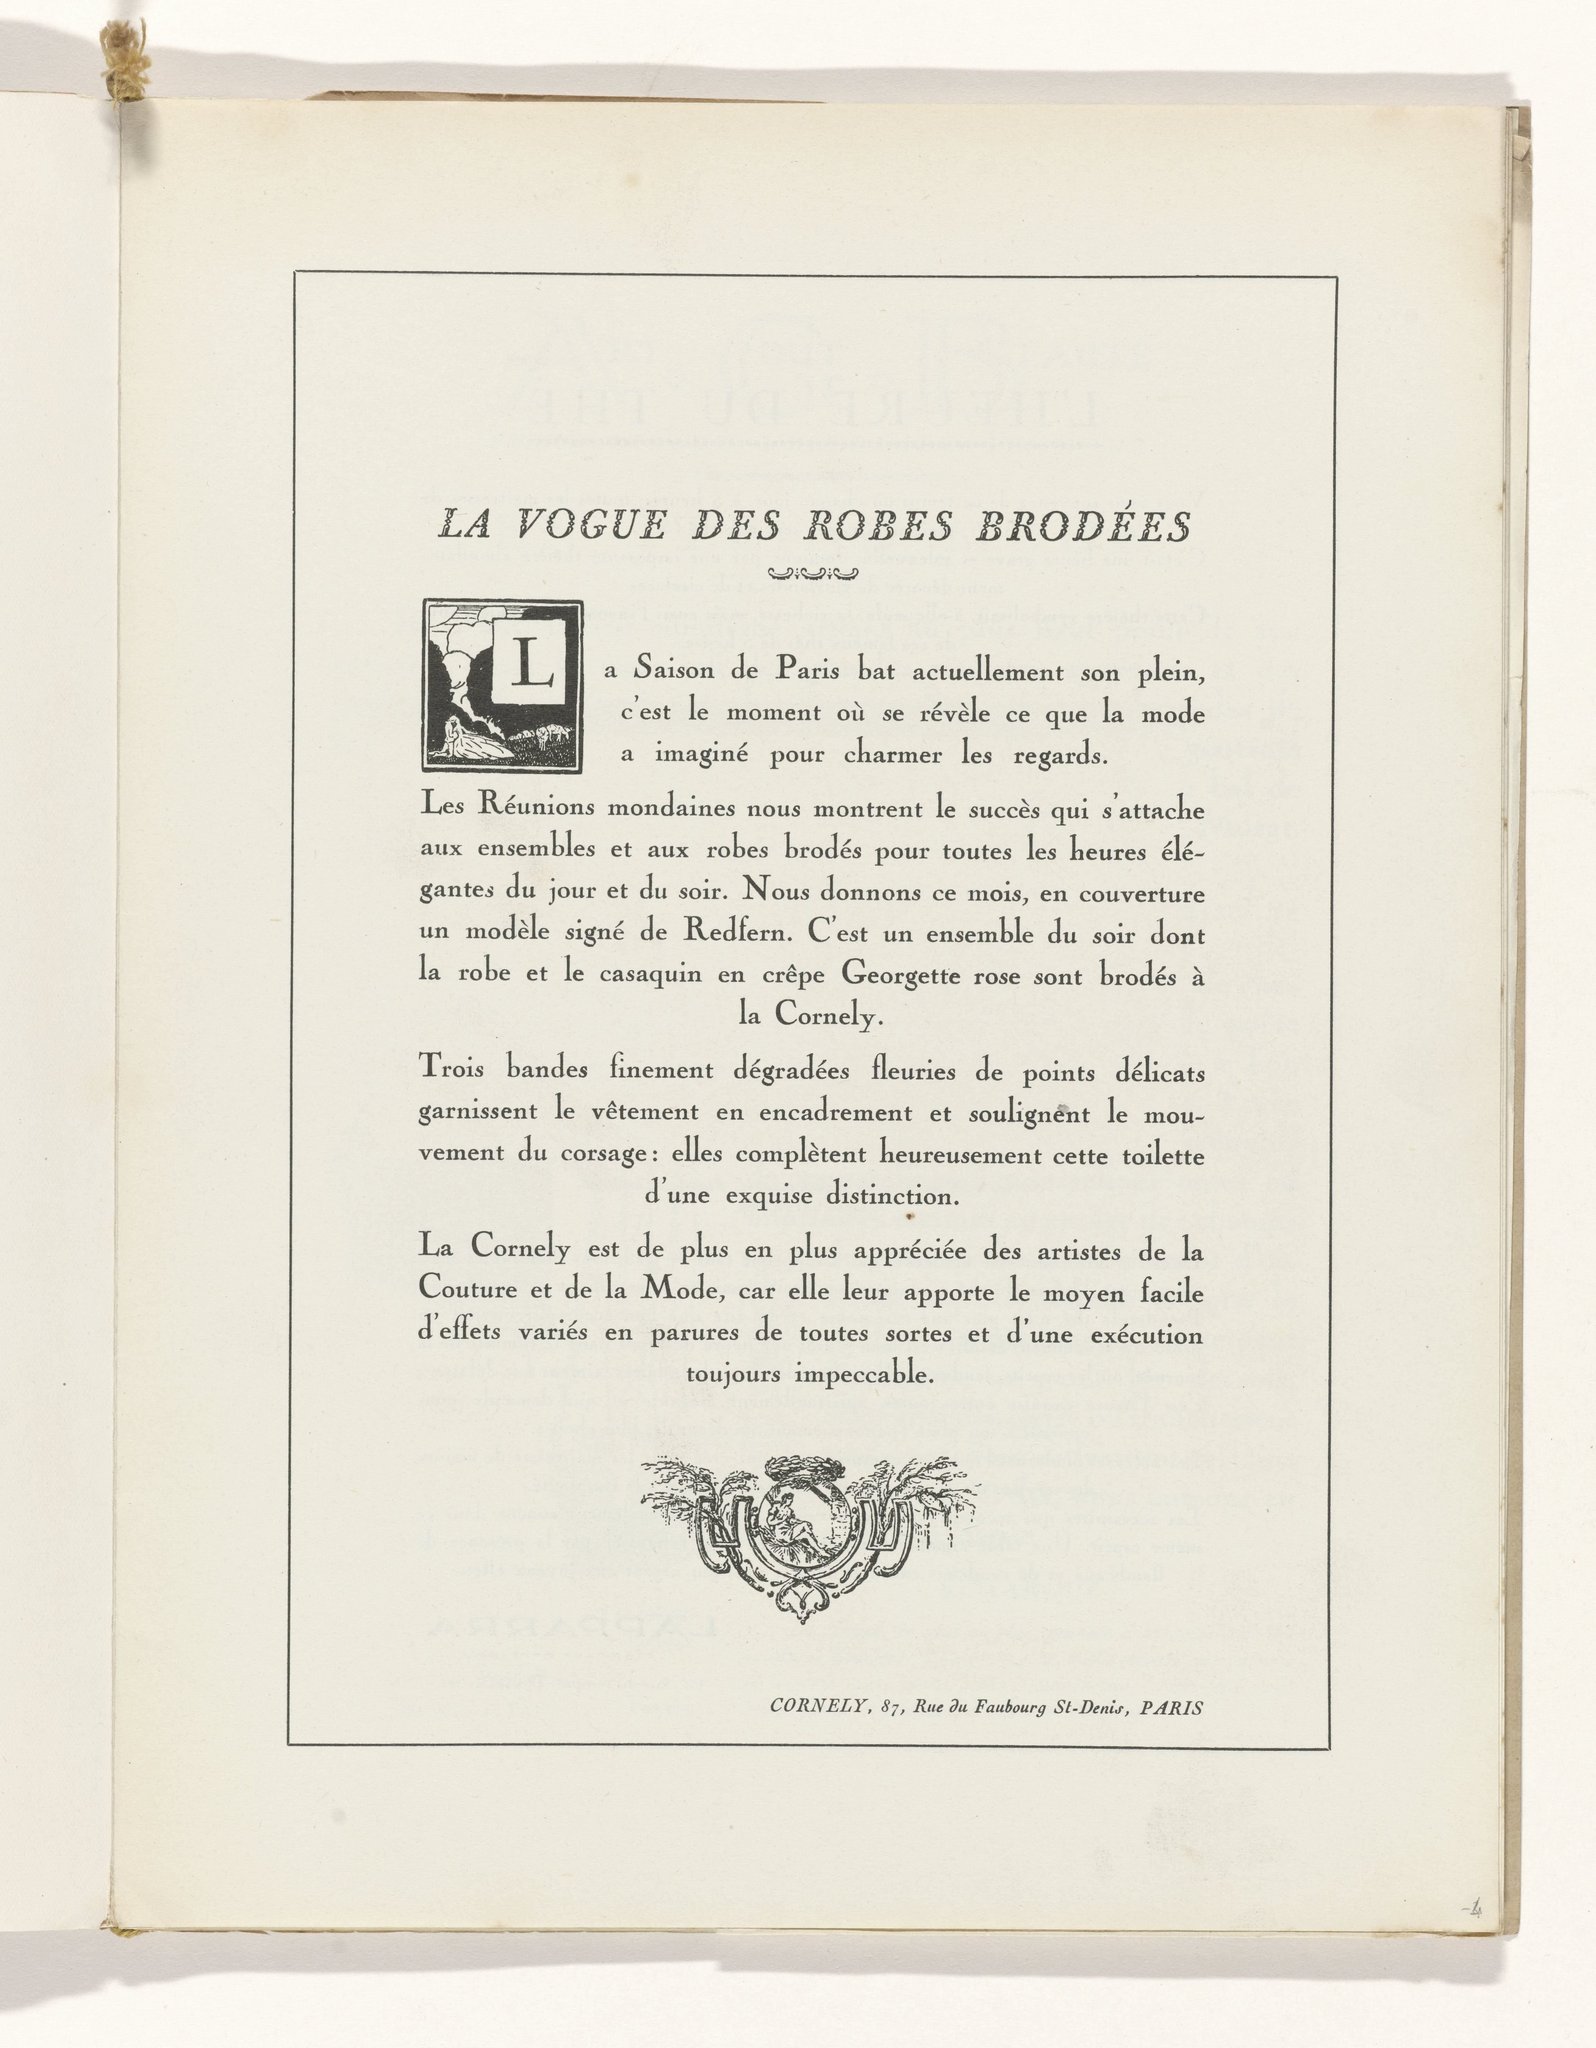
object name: magazine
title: Art - Goût - Beauté, Feuillets de l' élégance féminine, Juin 1929, No. 106, 9e Année, p.4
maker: charles goy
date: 1929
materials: paper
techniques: lithograph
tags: fashion plates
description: Tekst 'La vogue des robes brodées' over machinaal borduren 'à la Cornely' (Adres: 87, Rue du Faubourg St-Denis, Paris). Pagina uit het modetijdschrift Art-Goût-Beauté (1920-1933).